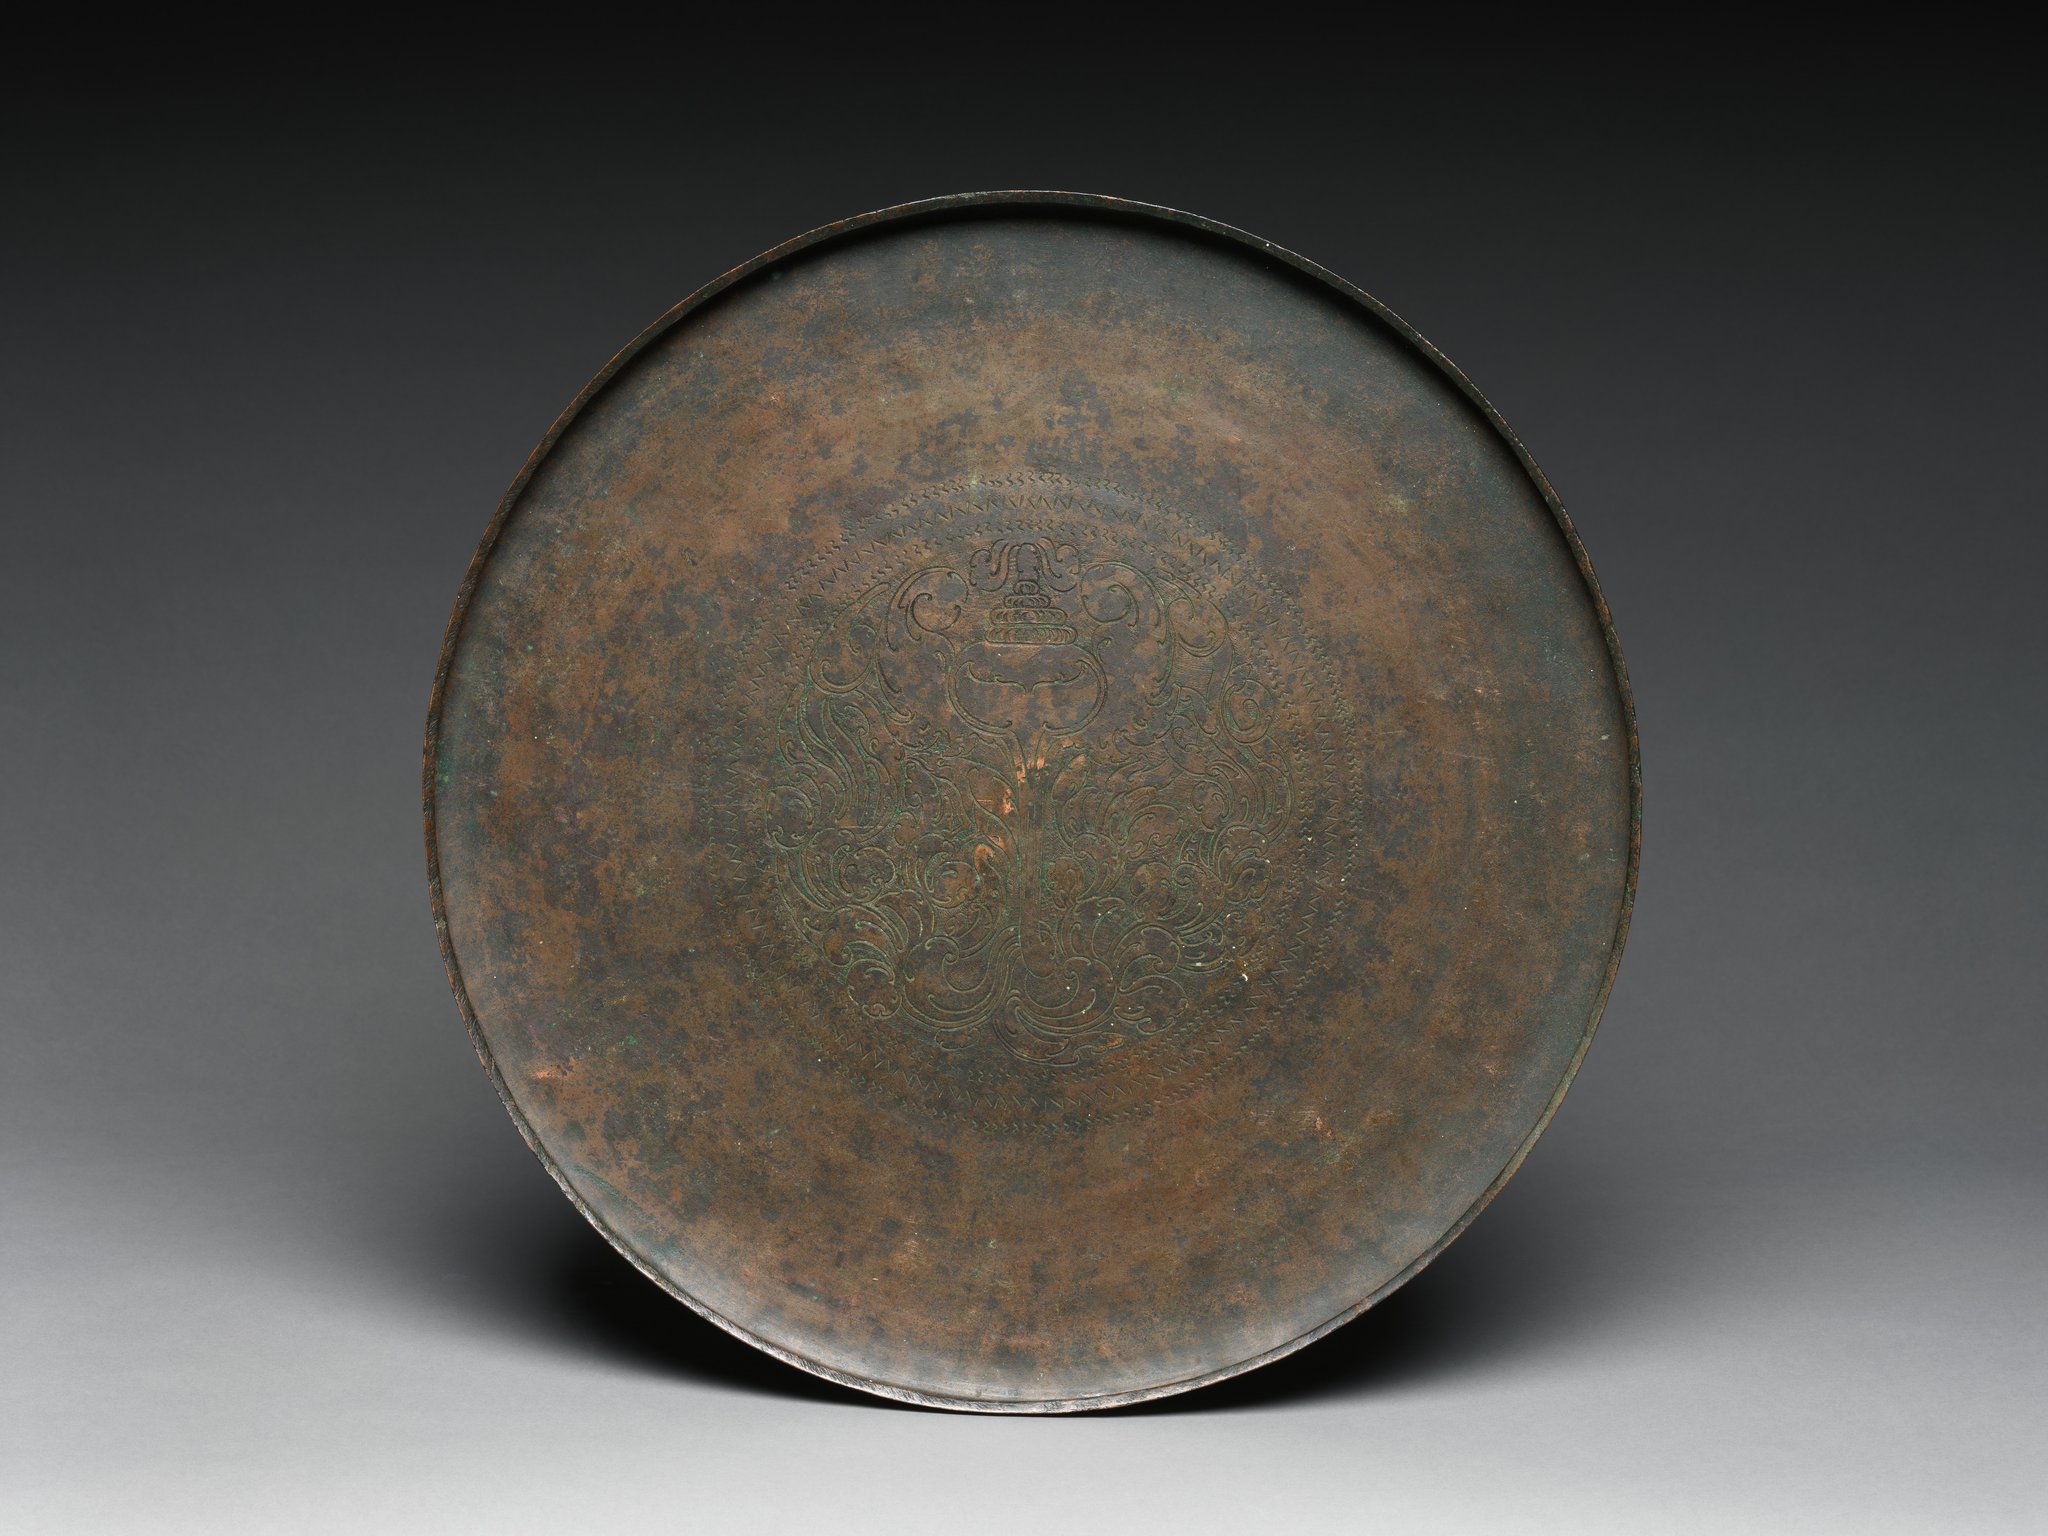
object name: tray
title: Offering tray (talam)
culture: indonesian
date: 1101-1400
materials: copper alloy